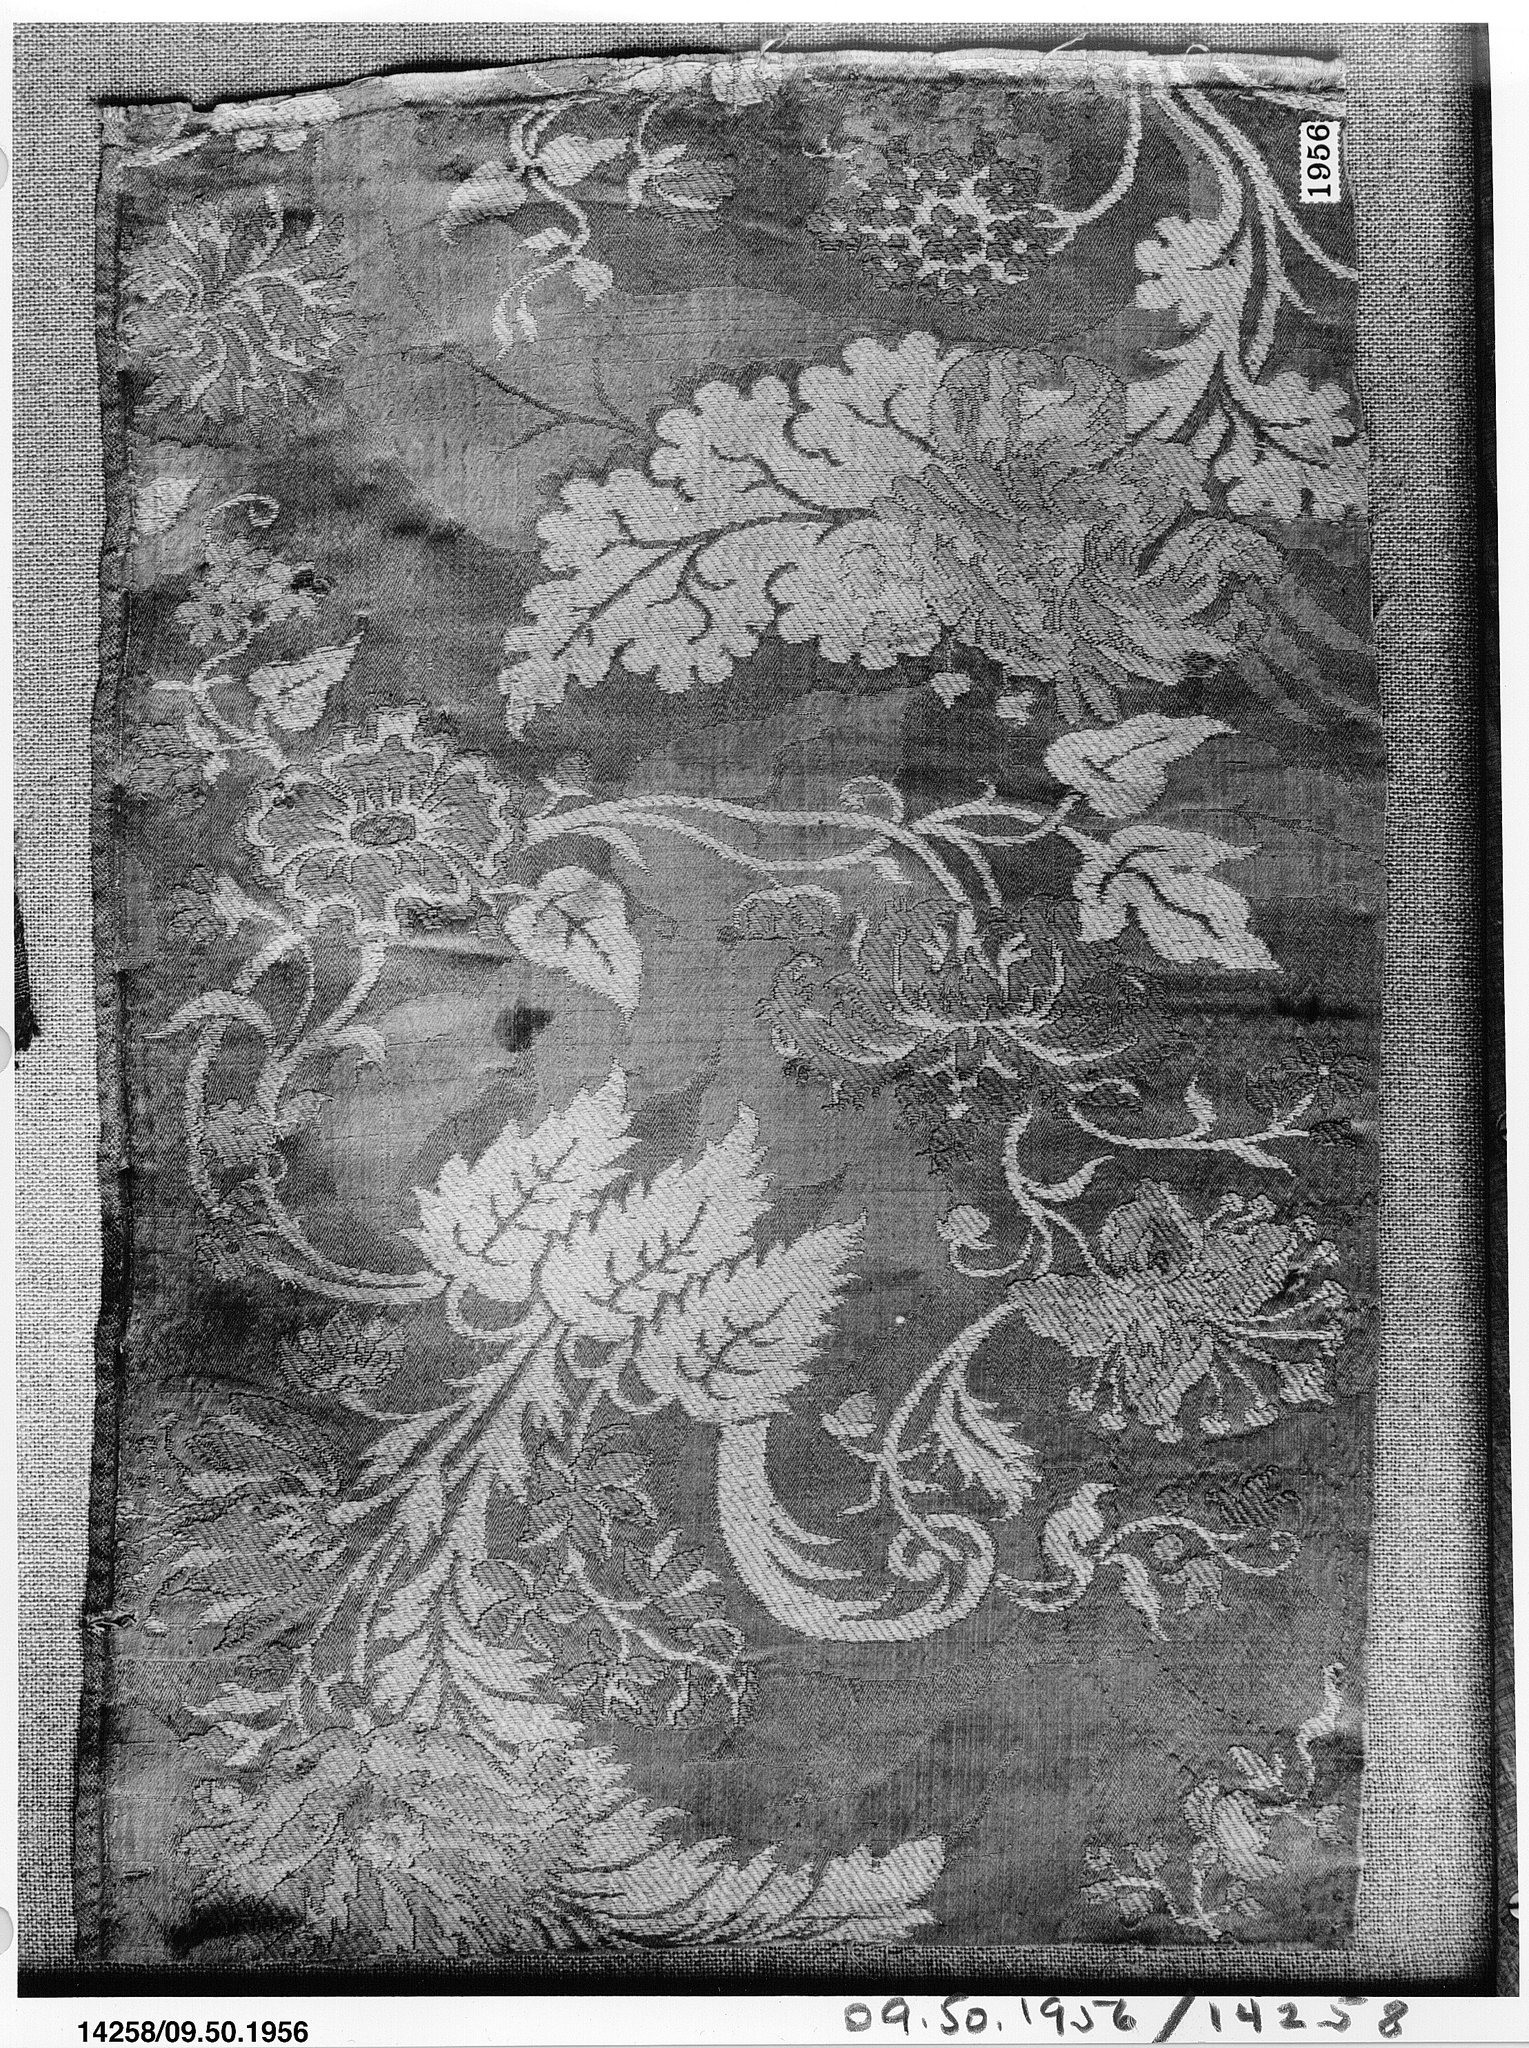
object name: piece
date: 1701-1733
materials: silk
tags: flowers,leaves